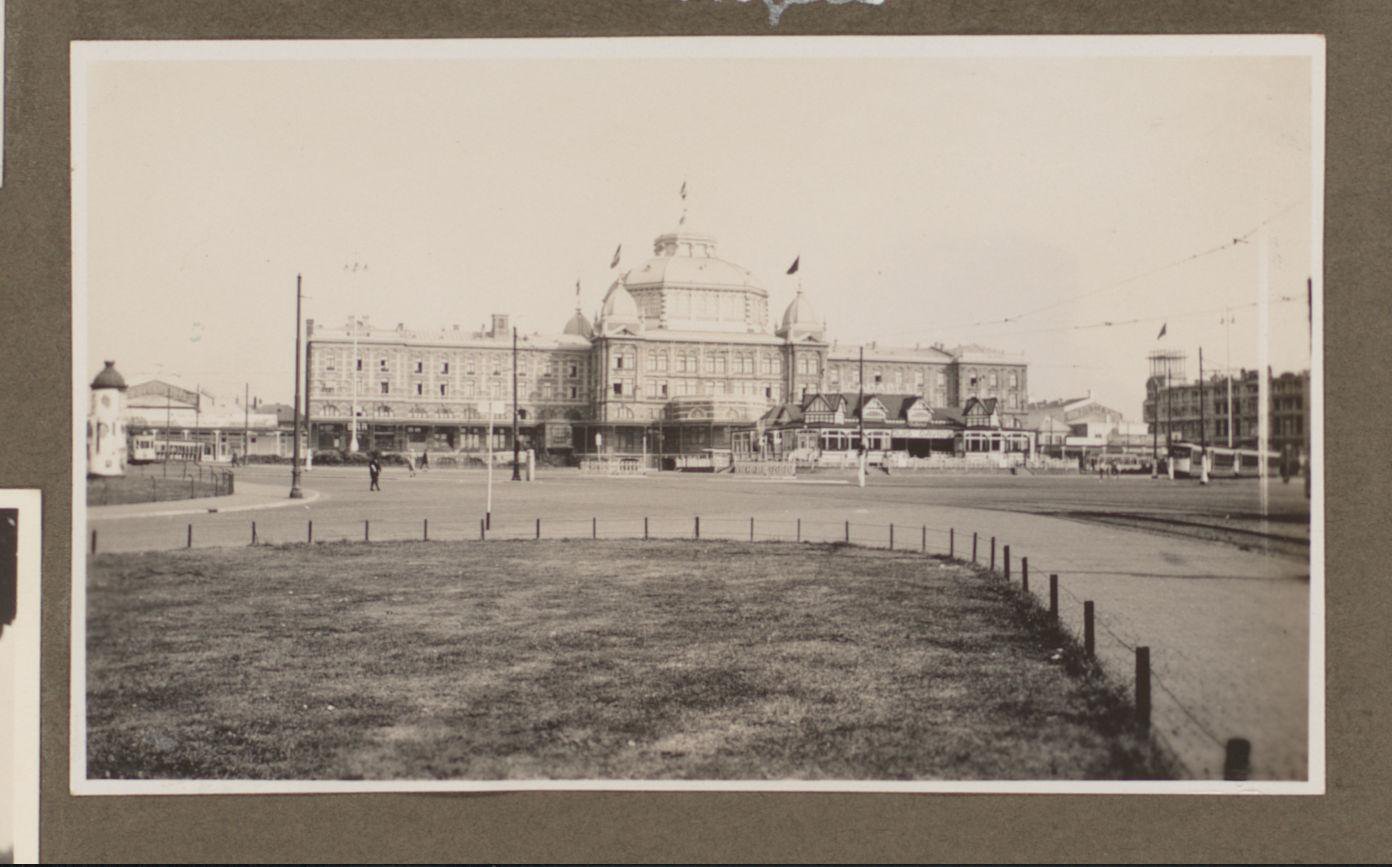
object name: photograph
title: Gezicht op het Kurhaus, Scheveningen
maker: Anonymous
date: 1932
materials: paper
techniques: gelatin silver print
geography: scheveningen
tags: hotel, hostelry, inn